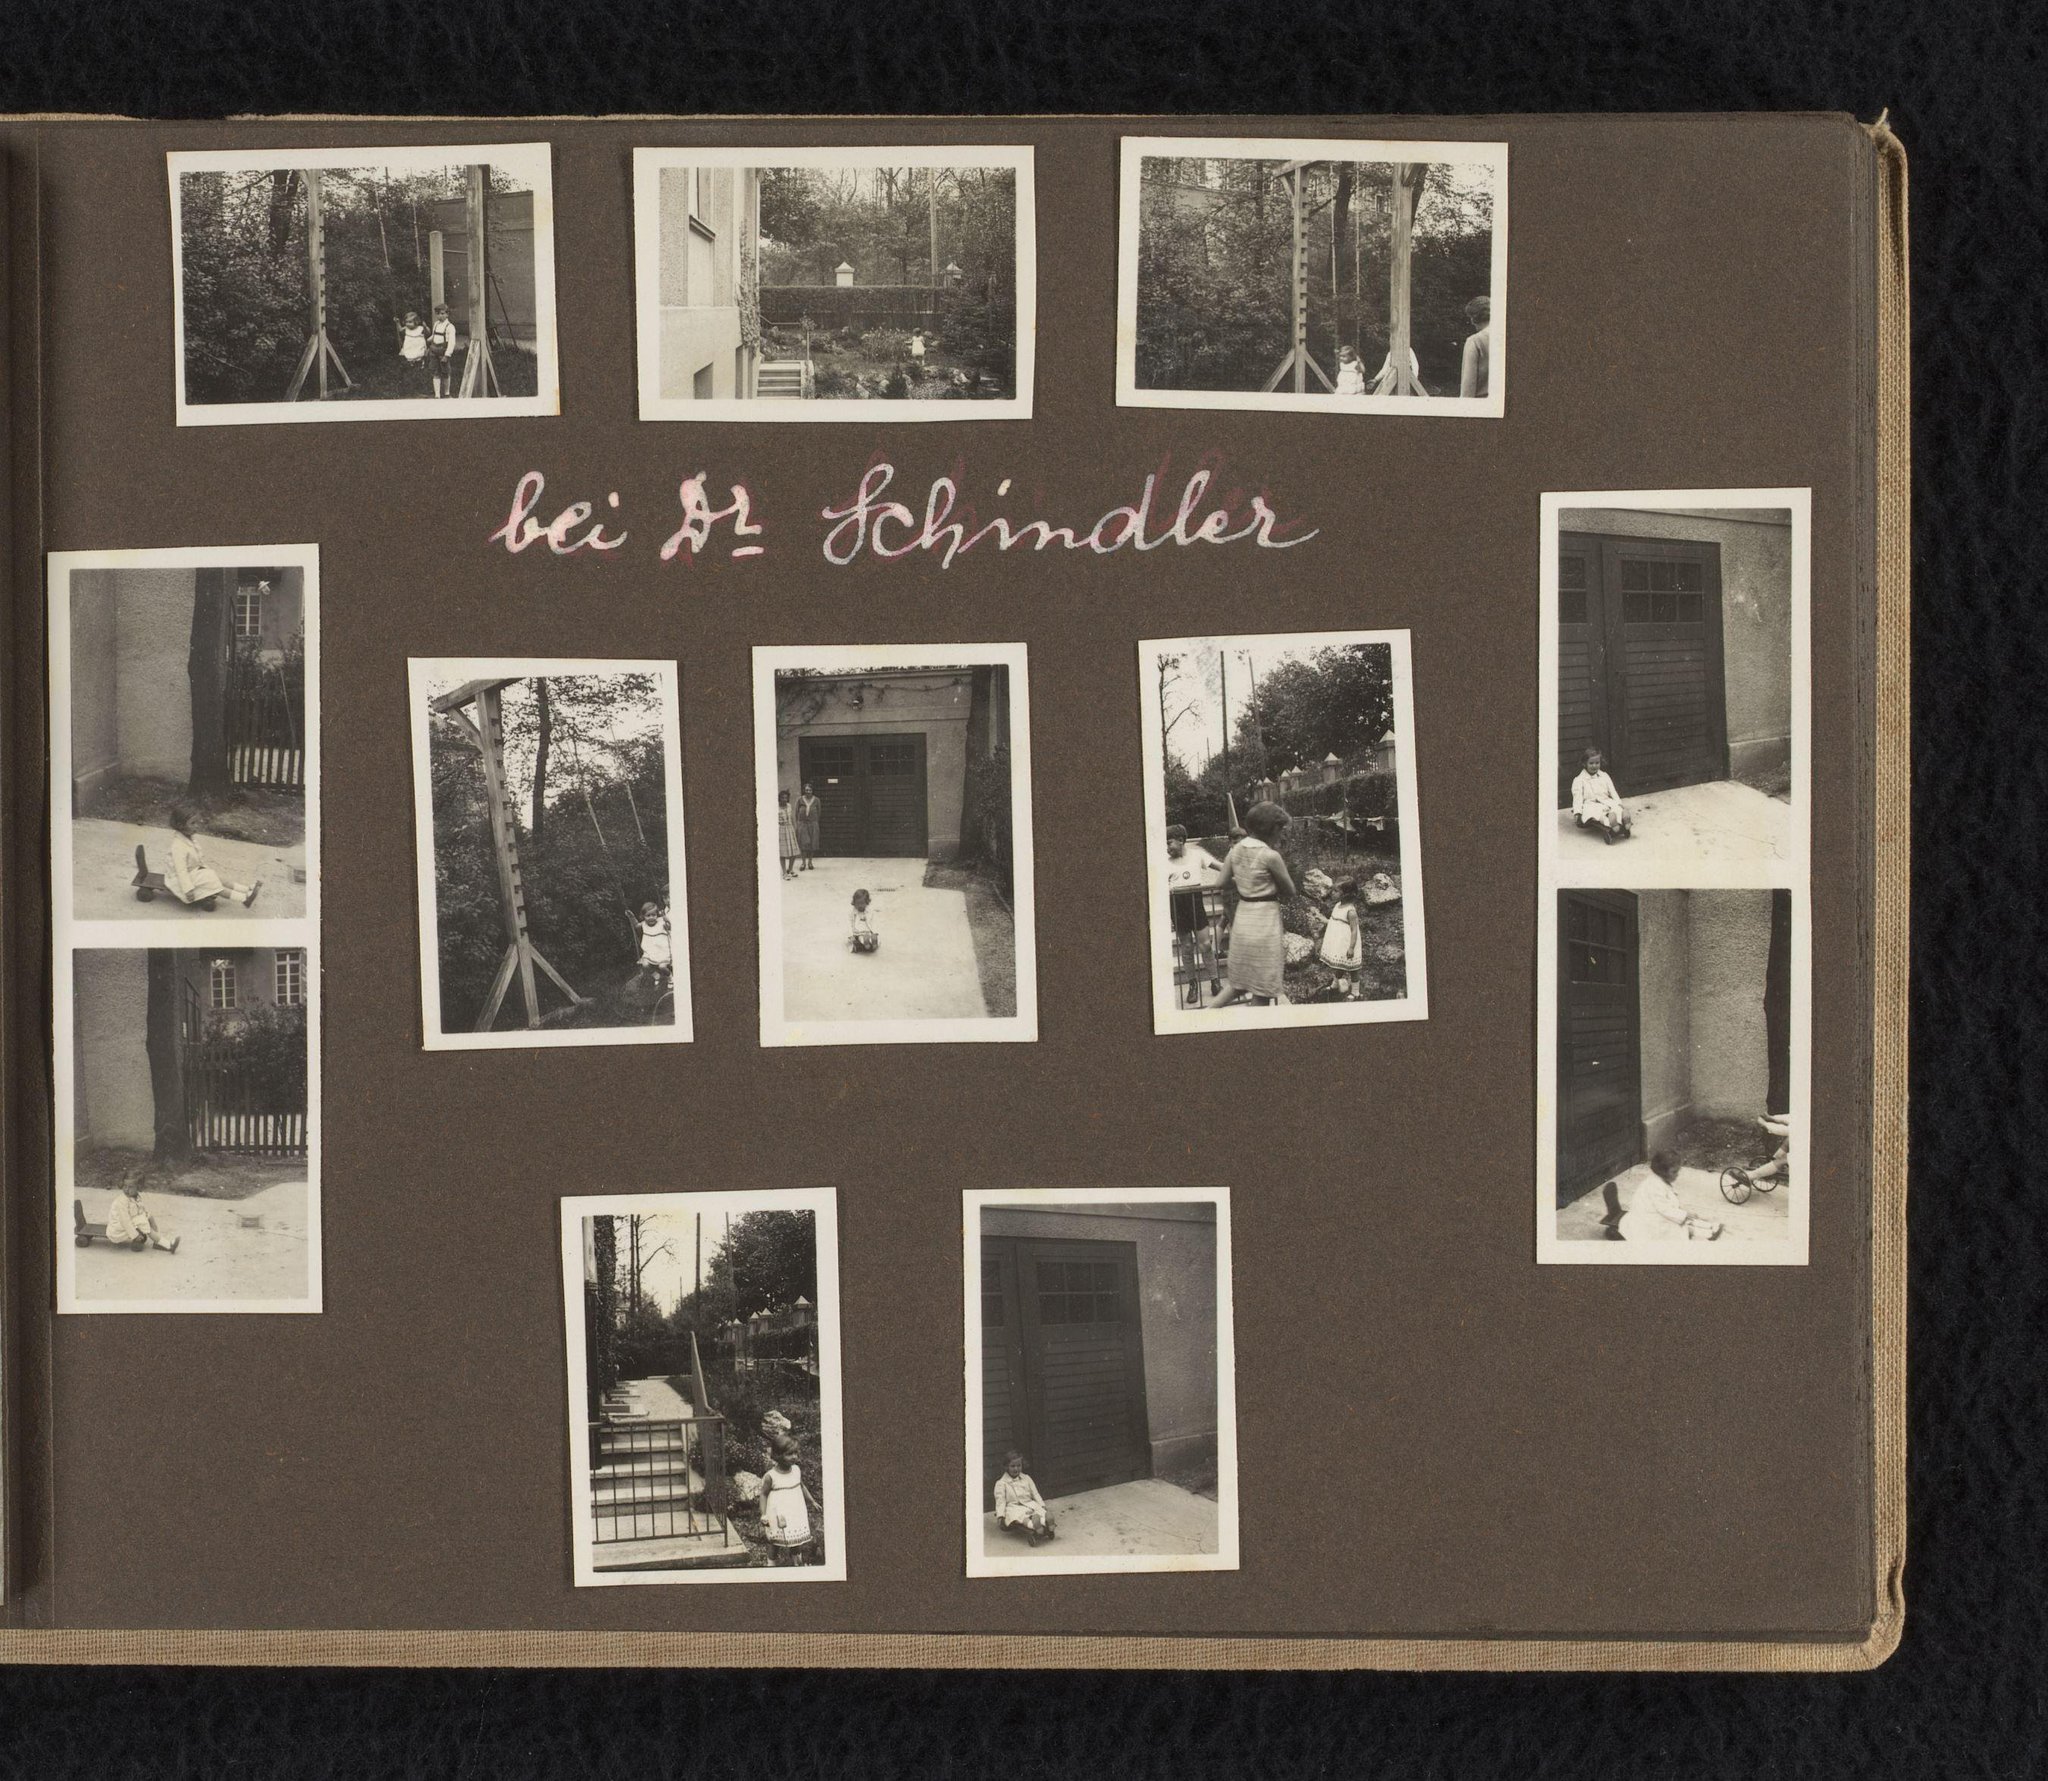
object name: photograph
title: Isabel Wachenheimer in de tuin van dr. Schindler, mei-juni 1931, München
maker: else wachenheimer-moos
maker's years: 1895-1944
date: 1905-1931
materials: cardboard, photographic support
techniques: gelatin silver print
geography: munich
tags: isabel wachenheimer-elon, family life at home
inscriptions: inscription: ‘bei Dr. Schindler’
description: Blad bevat twaalf foto's. Alle foto's van Isabel Wachenheimer (als klein meisje). Uit het album, half formaat, crèmekleurig stofomslag met koordbinding met banenmotief.